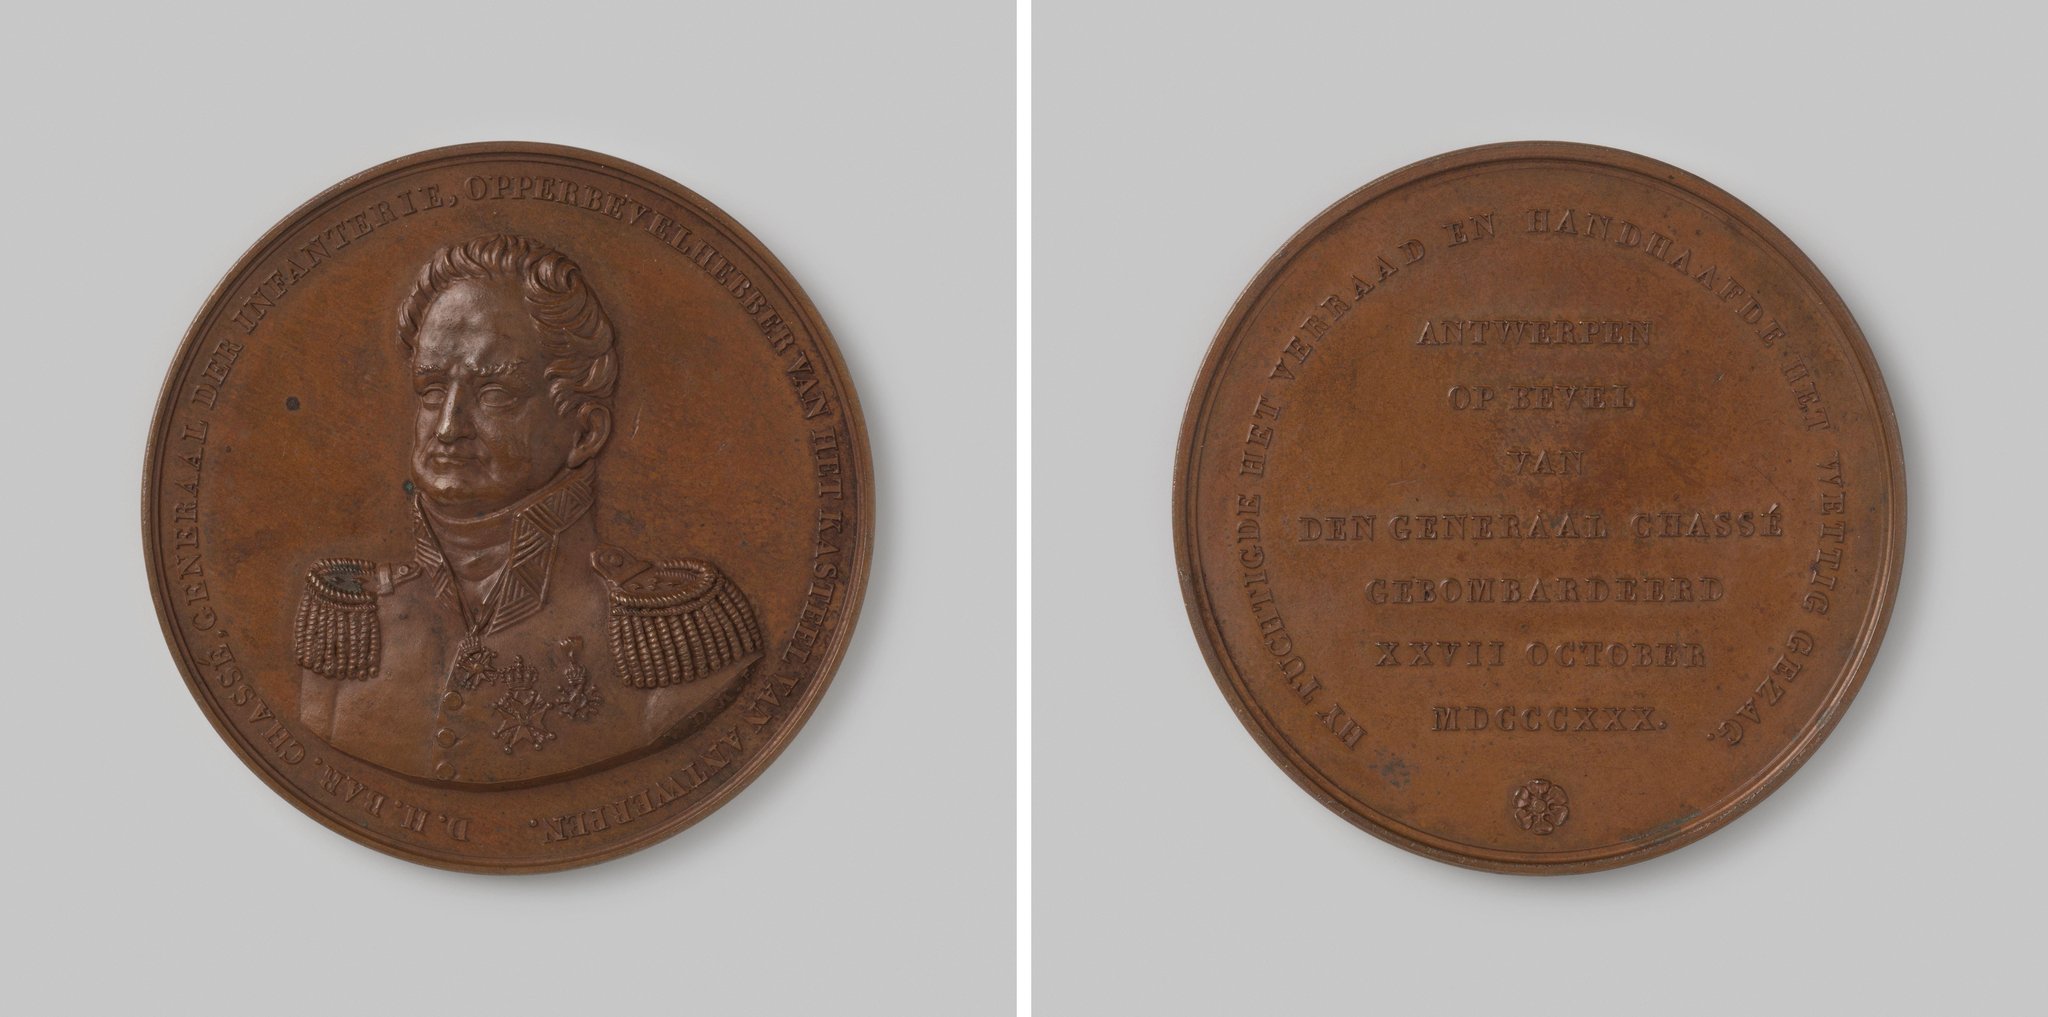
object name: history medal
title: Bombardement van Antwerpen door Generaal Chassé 1830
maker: david van der kellen (1804-1879)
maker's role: die cutter, draughtsman, print maker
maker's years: 1804-1879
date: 1830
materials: bronze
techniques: striking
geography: utrecht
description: Bronzen penning, op de voorzijde het borstbeeld van Chassé half naar links met omschrift, op de keerzijde zeven regels tekst met omschrift.